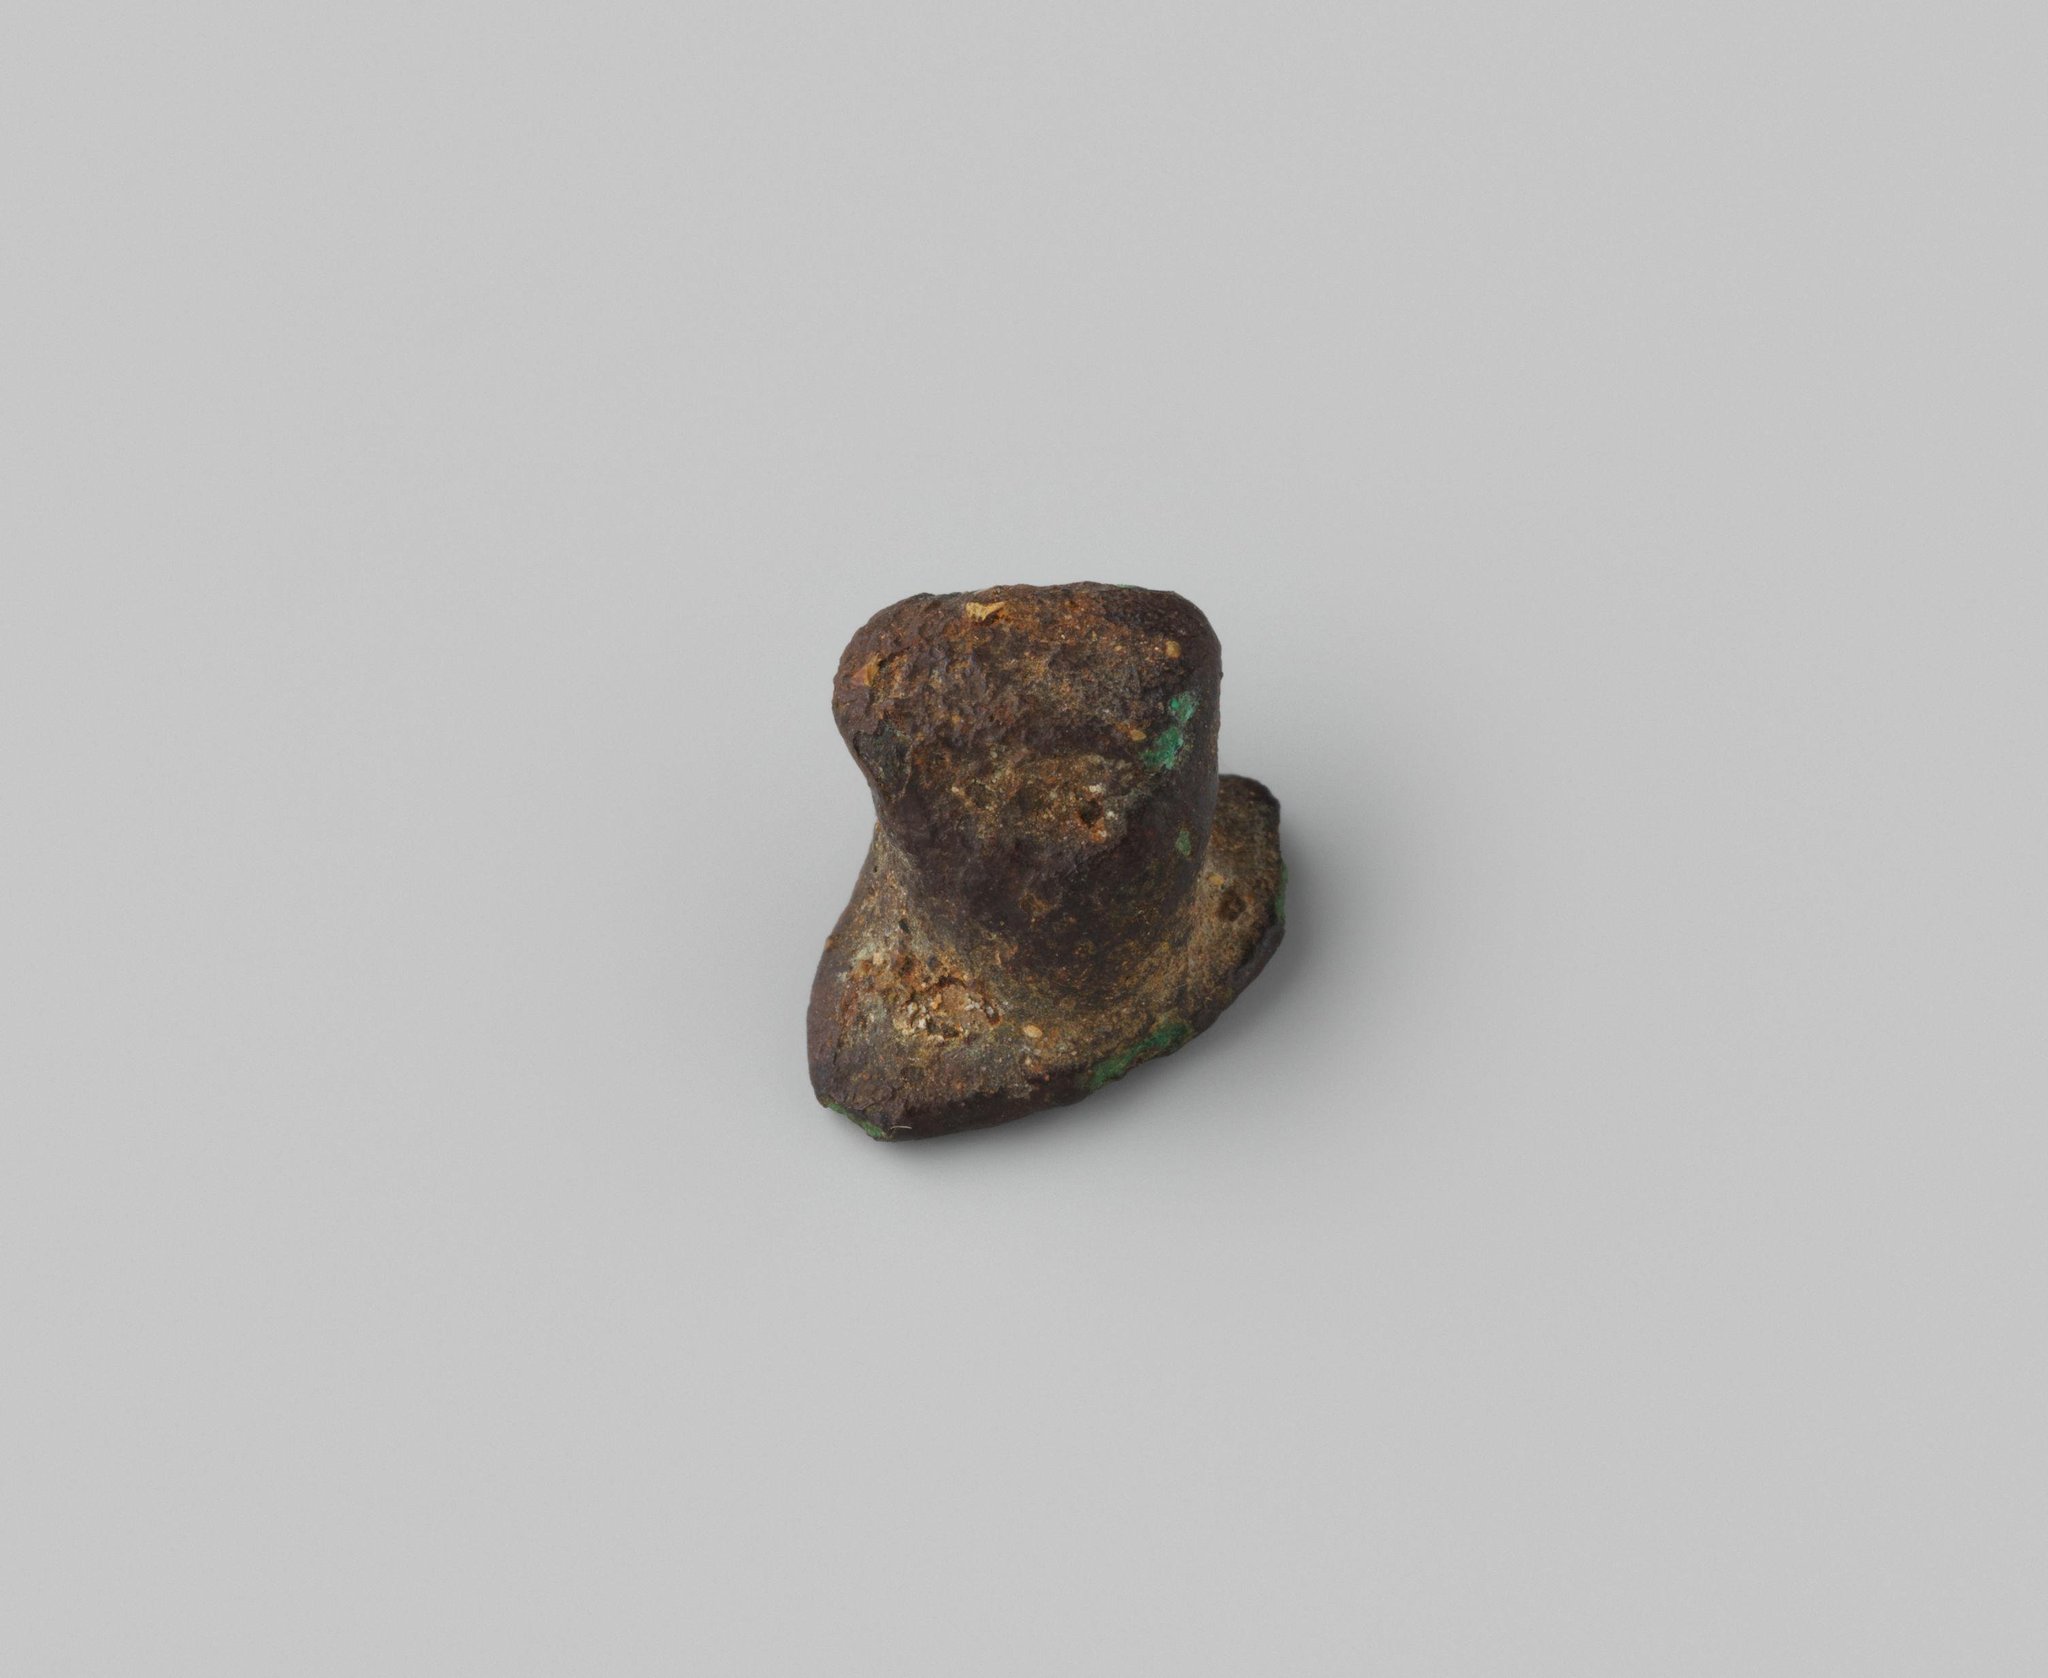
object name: rivet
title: Klinknagel afkomstig uit het wrak van de Oost-Indiëvaarder Hollandia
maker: Anonymous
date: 1700-1743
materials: copper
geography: netherlands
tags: verenigde oostindische compagnie, hollandia (schip)